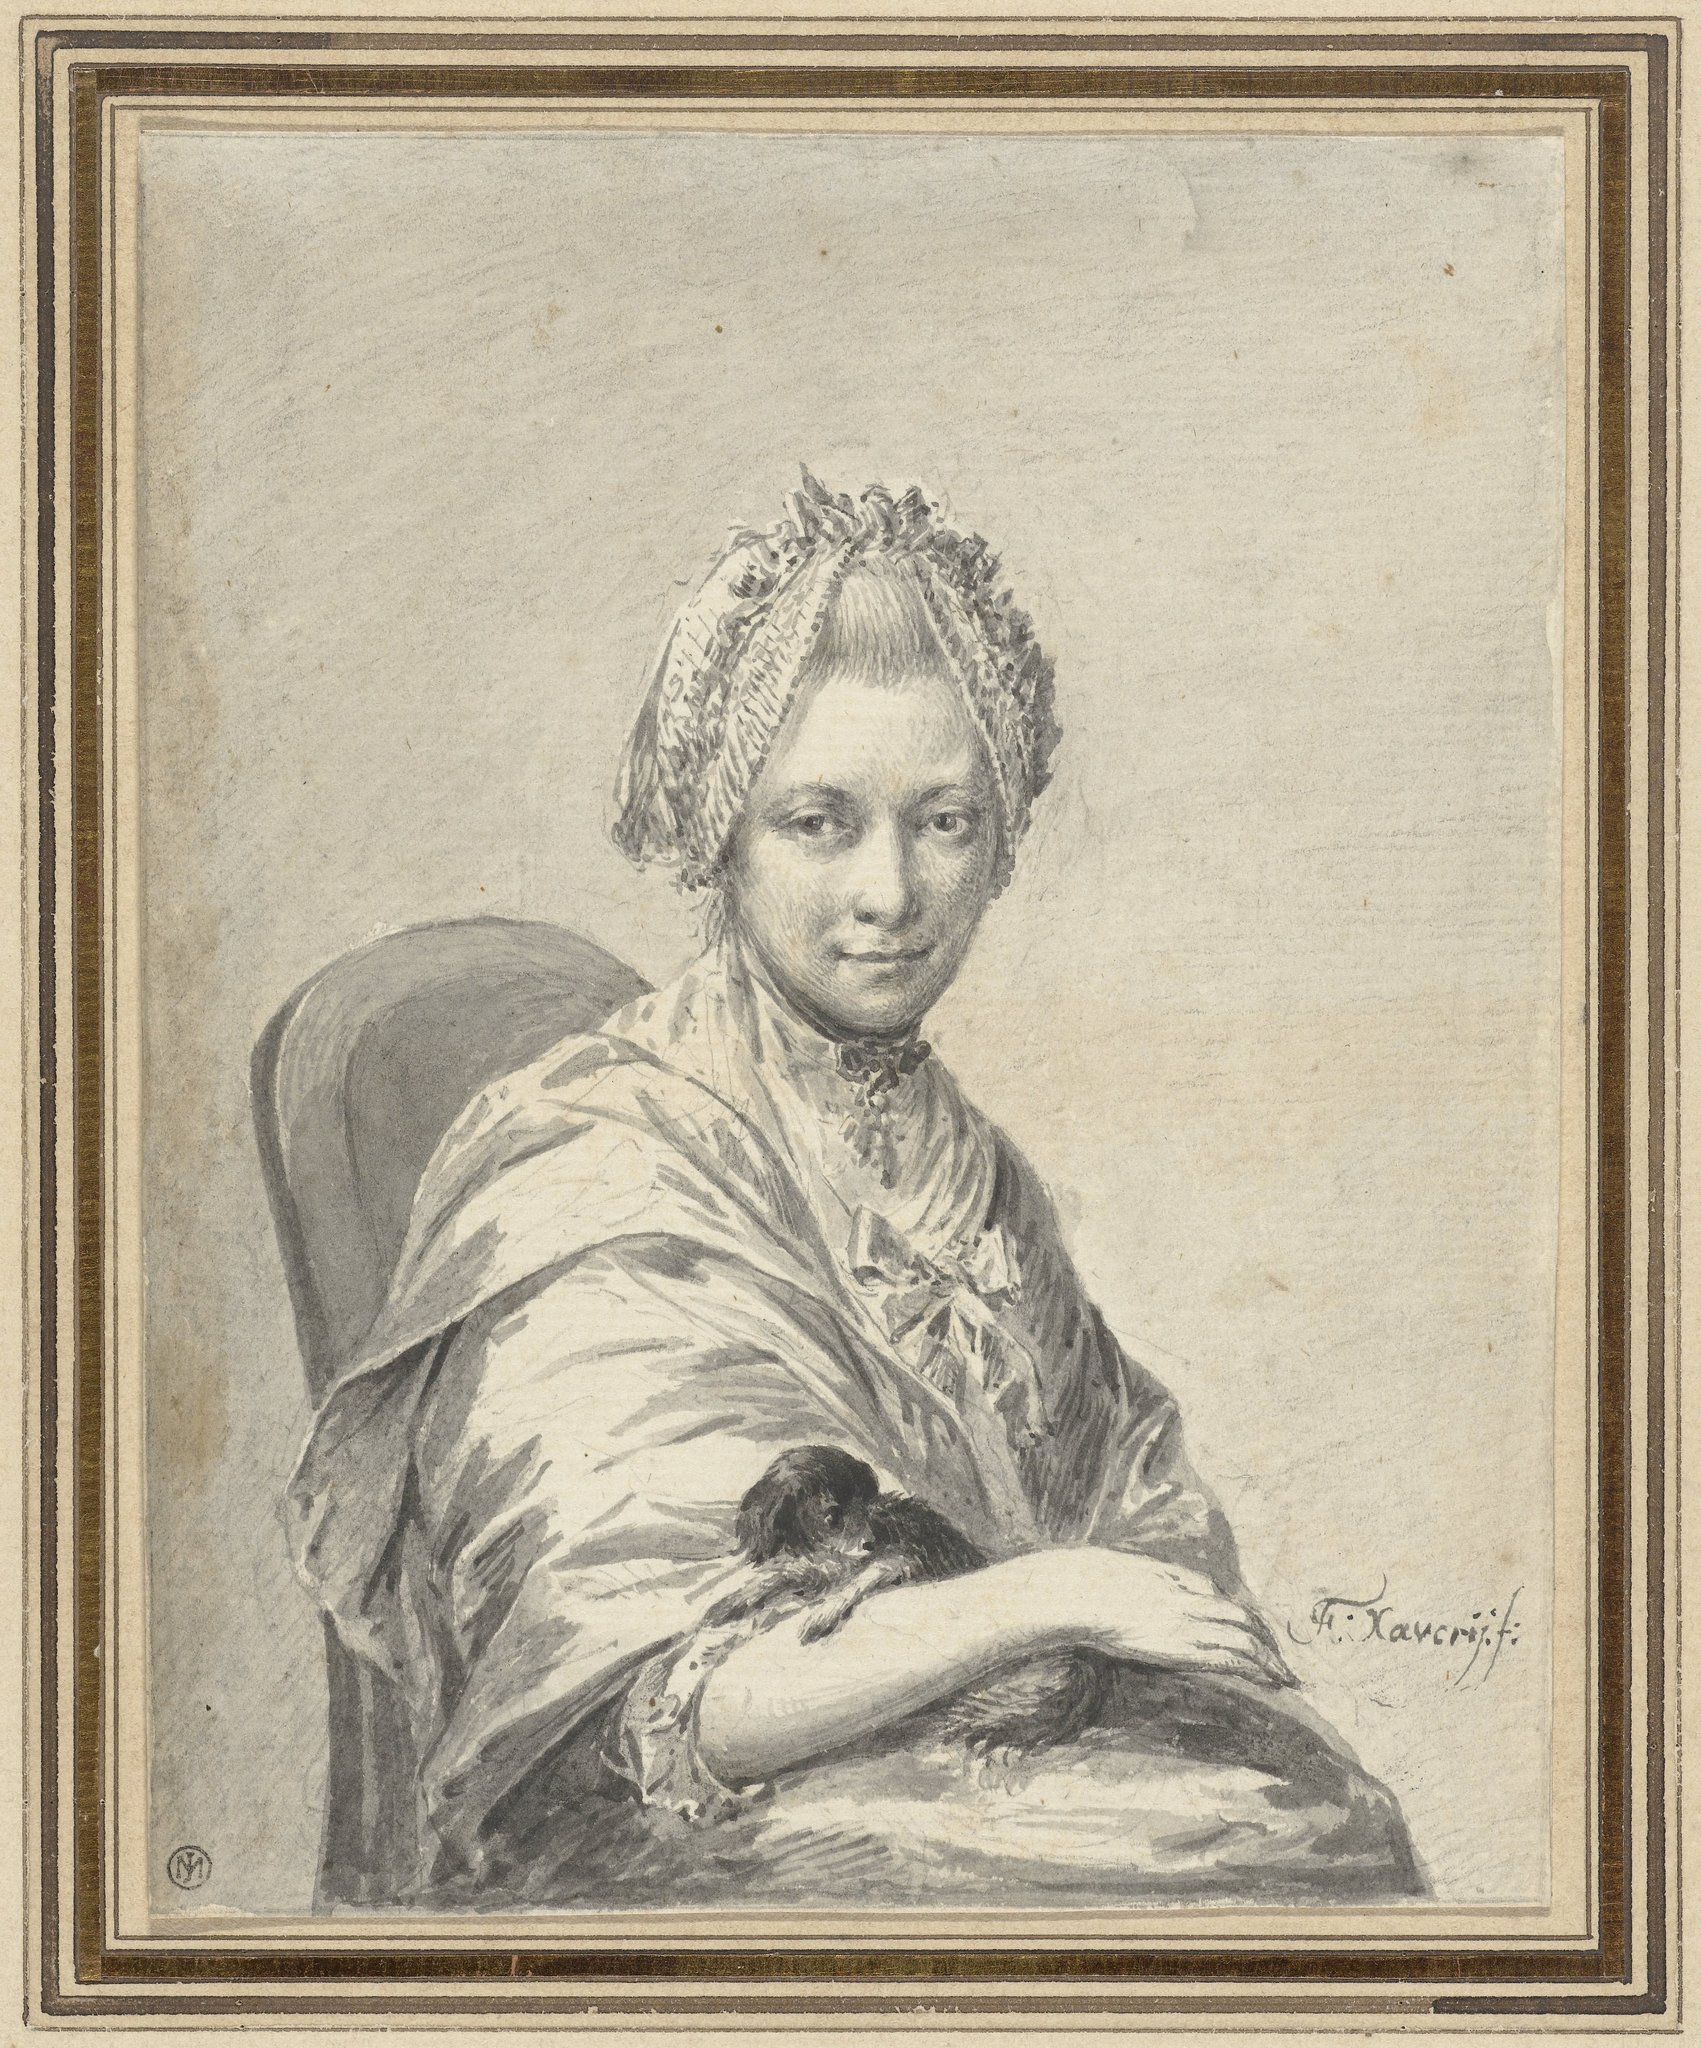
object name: drawing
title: Portret van een jonge vrouw met een hondje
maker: franciscus xaverius xavery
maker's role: draughtsman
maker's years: 1740-1772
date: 1750-1777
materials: paper, pencil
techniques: brush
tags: anonymous historical person portrayed alone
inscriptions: signature: ‘F : Xavery. f:’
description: Portret van jonge vrouw in stoel, driekwart naar rechts, met pekinees hondje op haar schoot.